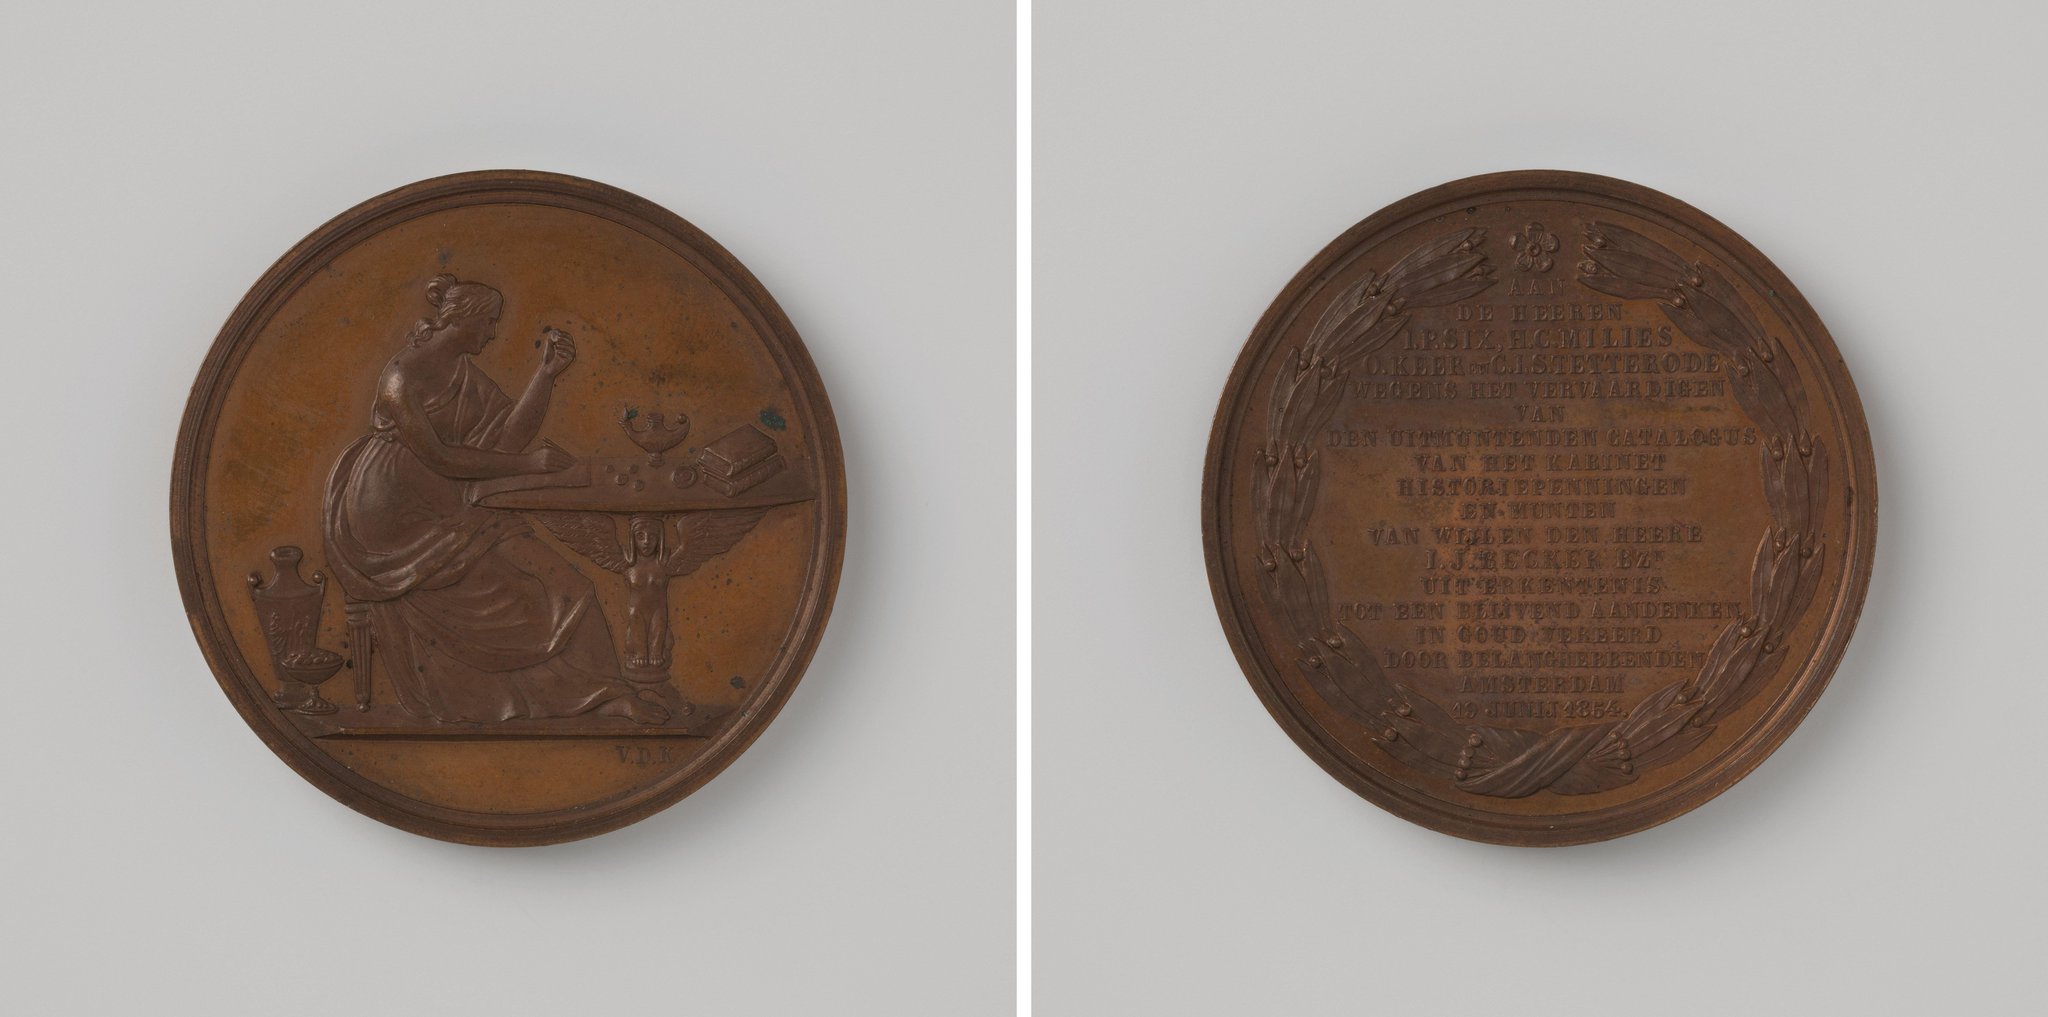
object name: history medal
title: Ter ere van de vervaardigers van de catalogus van de penningverzameling van J.J. Becker Bz. 1854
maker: david van der kellen (1804-1879)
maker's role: die cutter, draughtsman, print maker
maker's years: 1804-1879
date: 1854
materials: bronze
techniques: striking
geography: utrecht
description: Bronzen penning, op de voorzijde de Penningkunde als vrouw die een penning beschrijft, zittend aan tafel, op de keerzijde achttien regels tekst binnen een lauwerkrans.